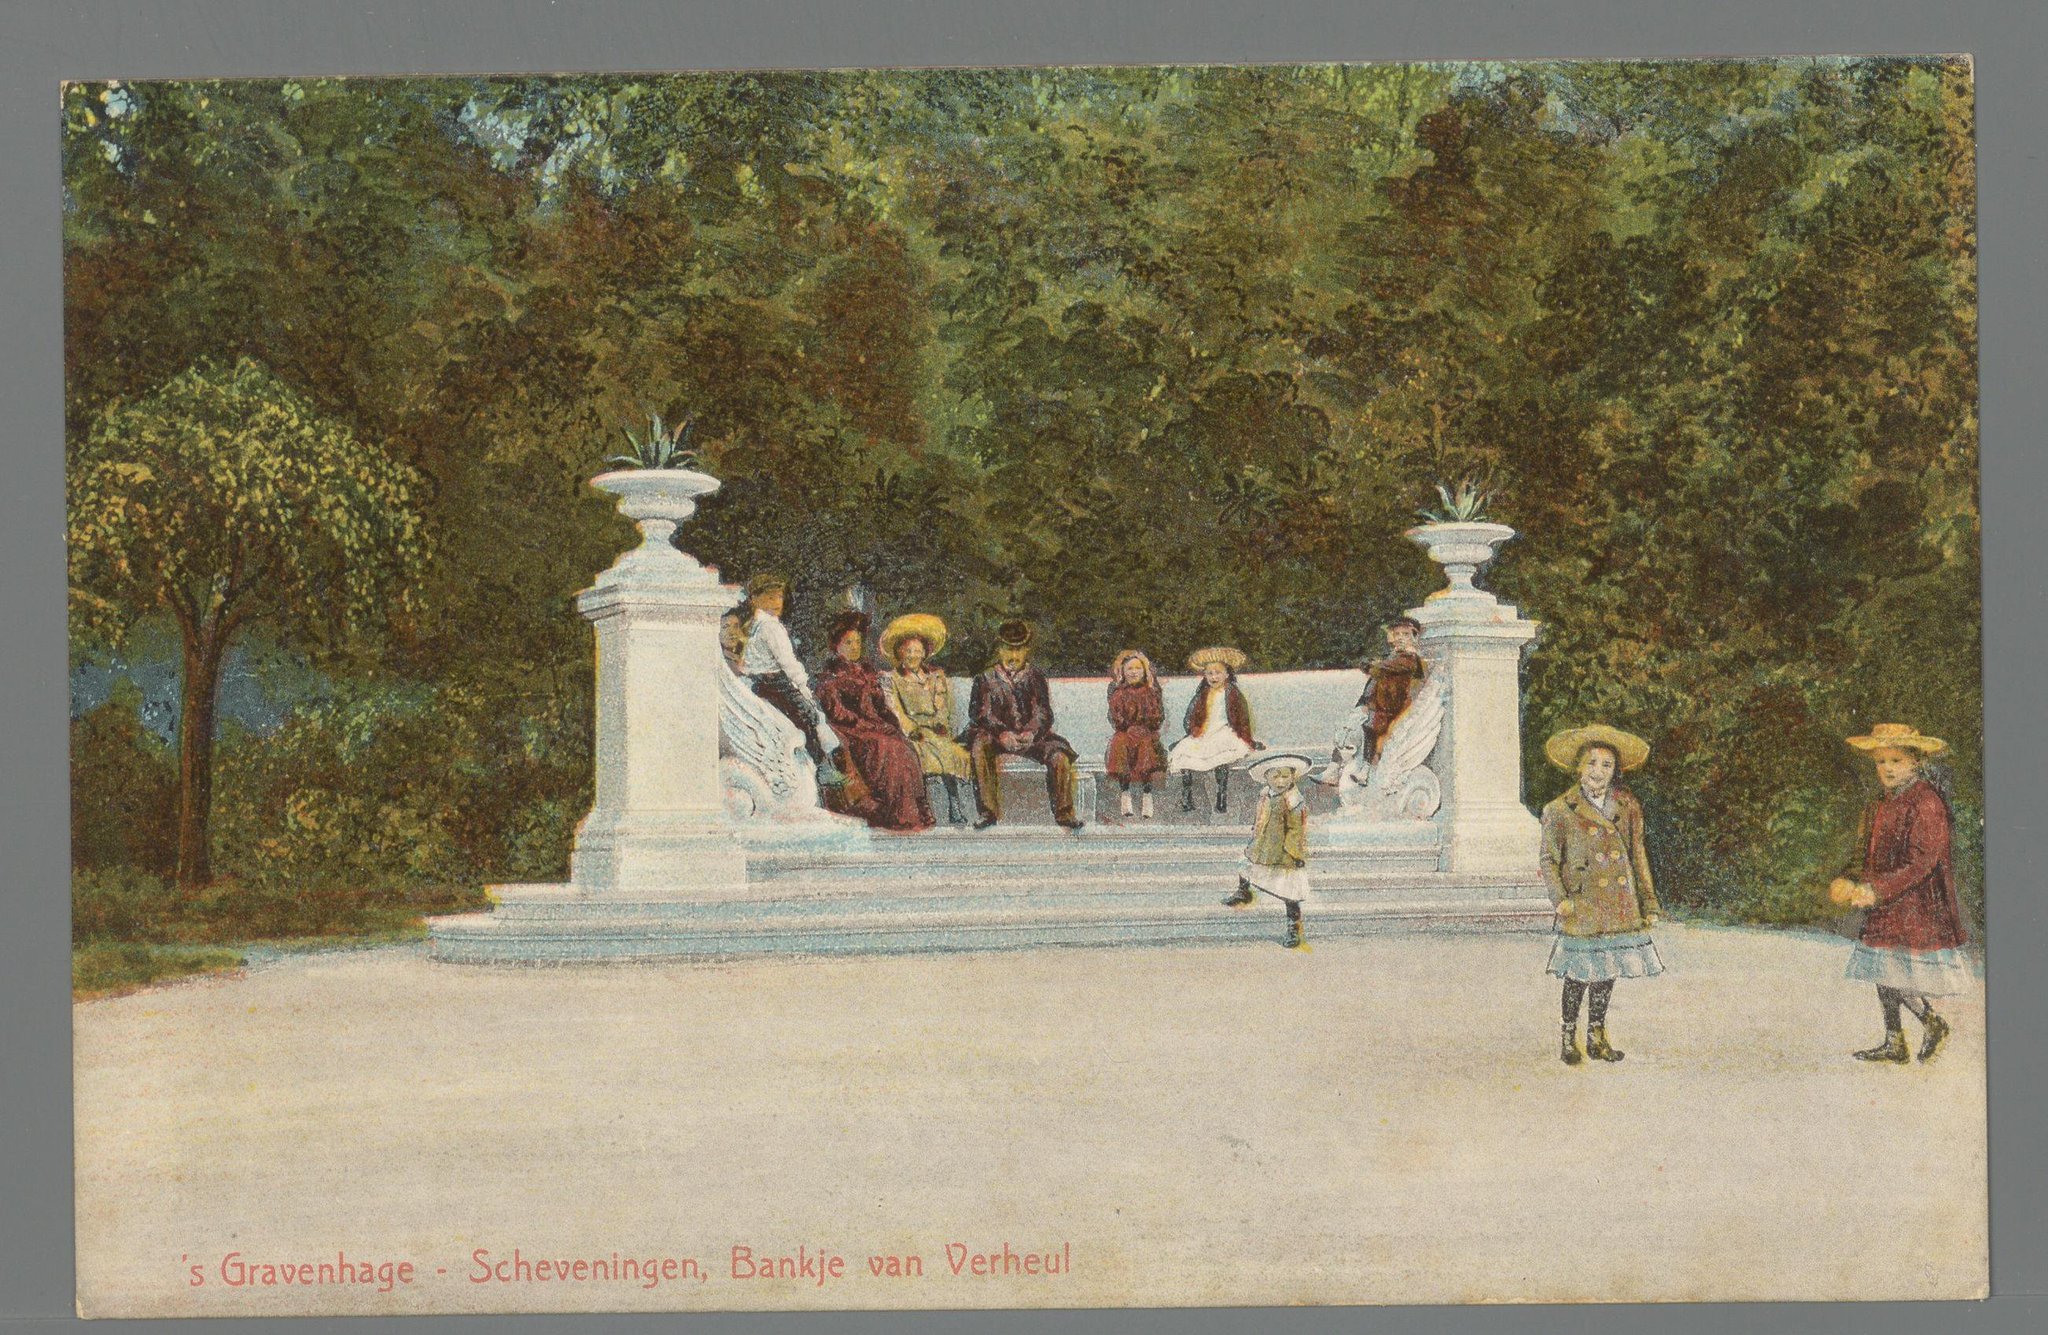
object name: ansichtkaart, prentbriefkaart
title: 's Gravenhage - Scheveningen, Bankje van Verheul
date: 1906-1926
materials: cardboard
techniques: photograph, lithograph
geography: scheveningen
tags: bench, forest, wood, monument, statue